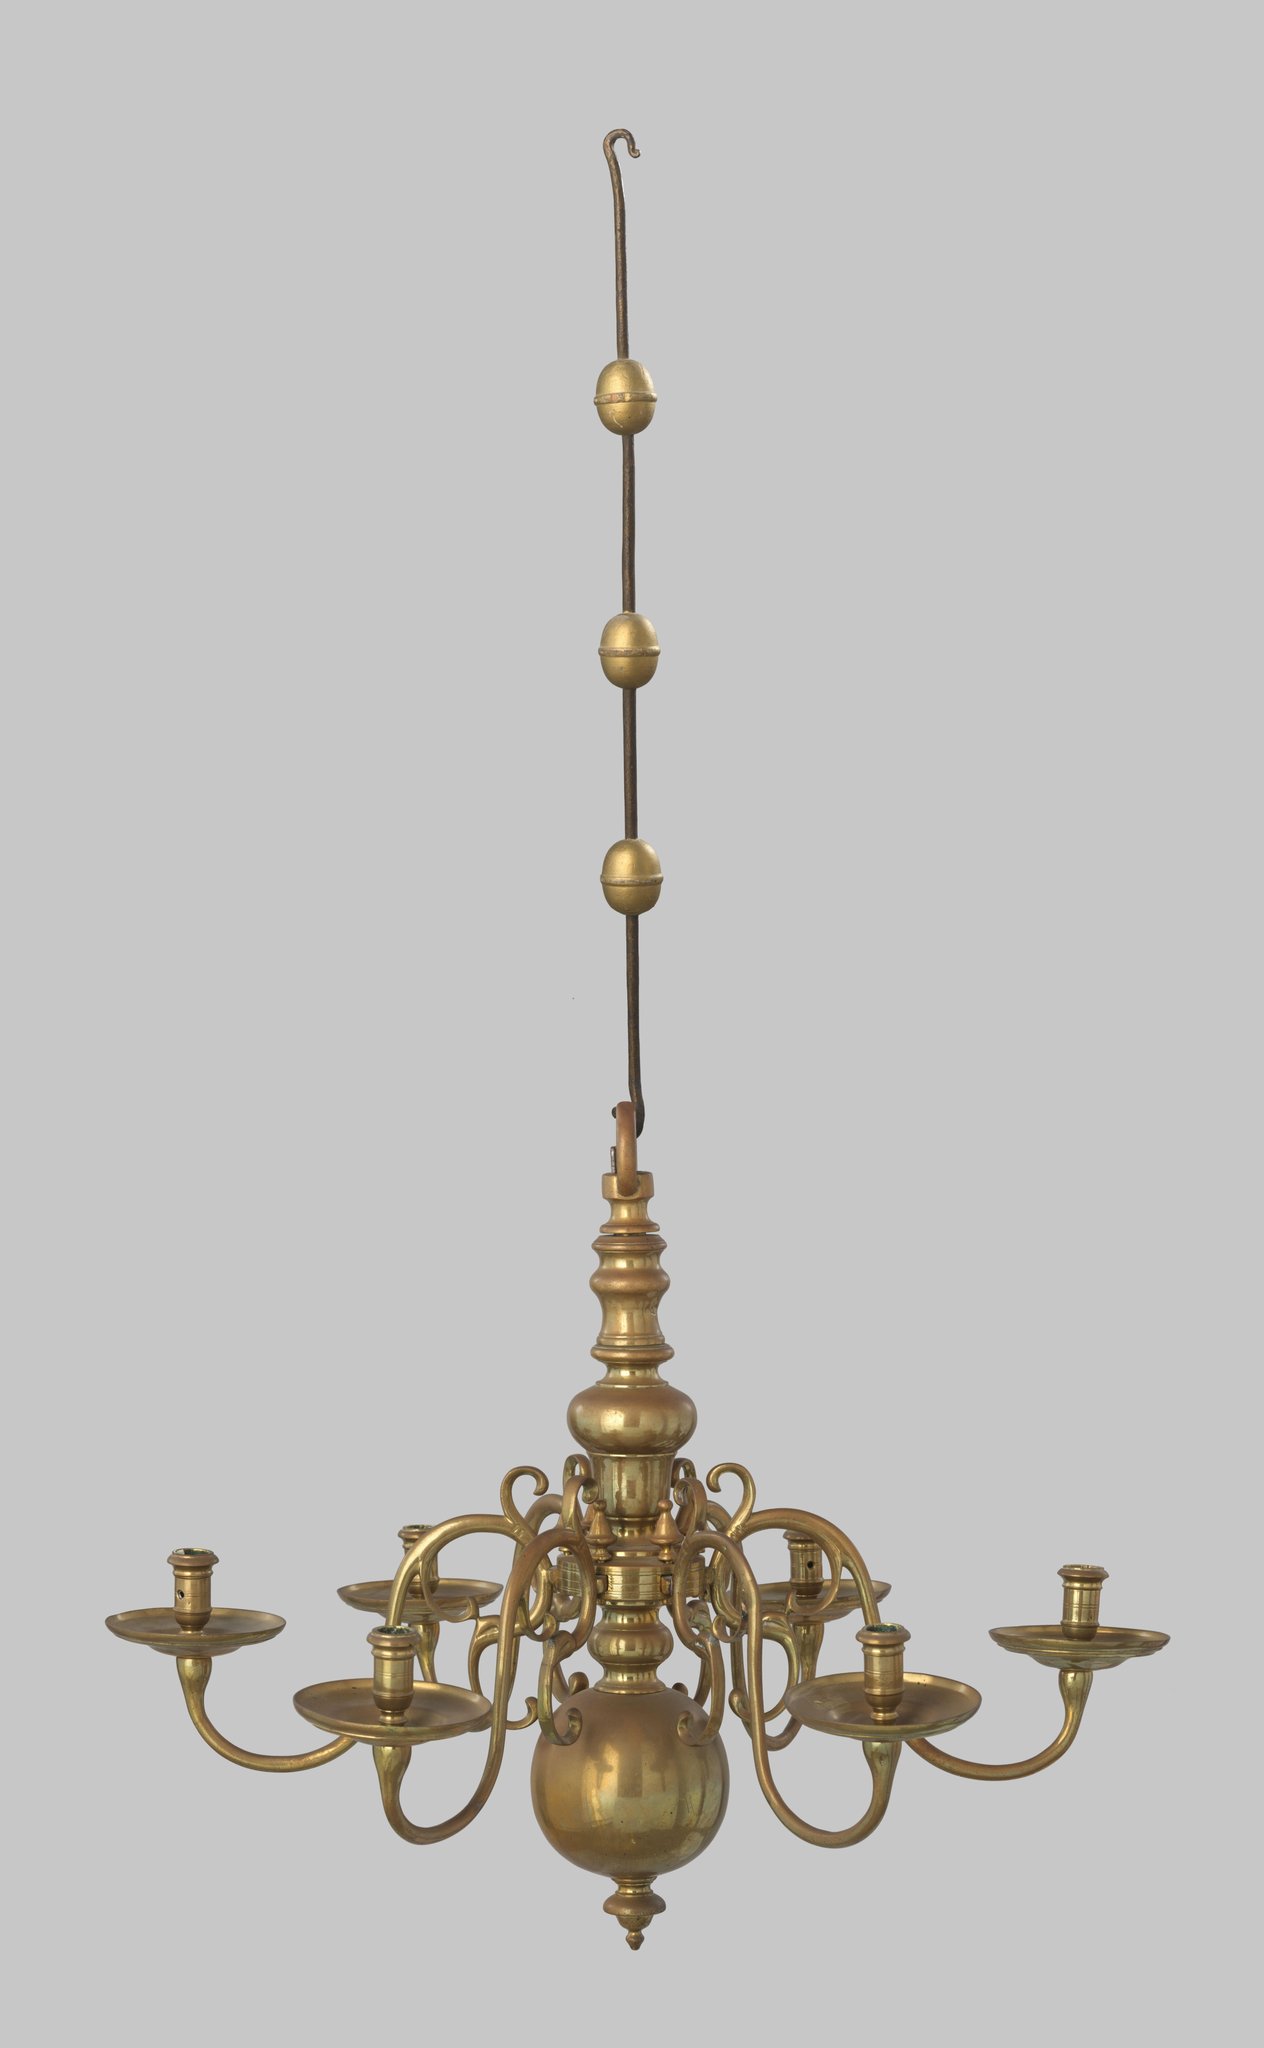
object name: chandelier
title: Arm van een kaarsenkroon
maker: Anonymous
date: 1700-1800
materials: brass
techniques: casting, screwed, turning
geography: northern netherlands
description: De S-vormige arm loopt naar de stam toe uit in een gestileerde dolfijnenkop en naar buiten toe in een verdikking, waarin het schroefgat is aangebracht. Daarop is de ronde geprofileerde en met gegroefde ringen versierde kaarsenhouder met de aan de onderkant geprofileerde en met gegroefde ringen versierde vetvanger geschroefd. De arm, de vetvanger en de kaarsenhouder zijn met behulp van dezelfde modellen gegoten als de overige armen, vetvangers en kaarsenhouders. Dit is de vijfde arm van de middelste standring, gemarkeerd op de nok met vijf punten.